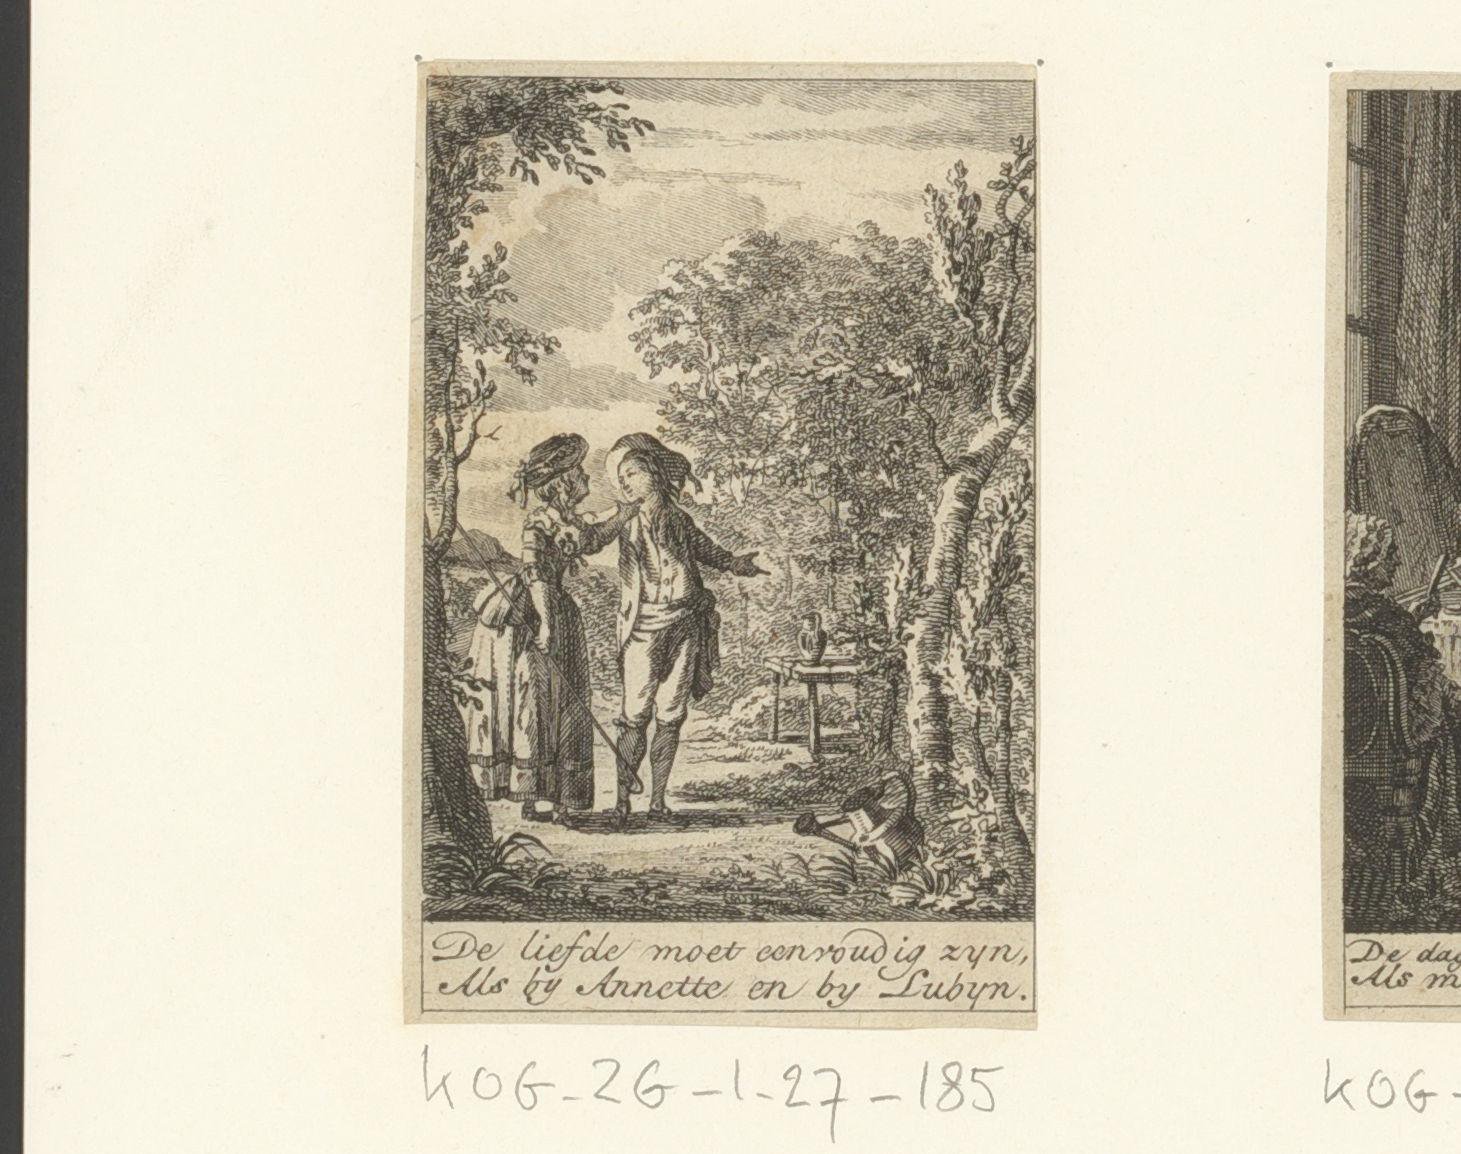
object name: print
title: Annette en Lubijn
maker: Anonymous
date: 1725-1799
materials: paper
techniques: engraving, etching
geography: netherlands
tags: lovers' meeting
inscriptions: collector's mark, collector's mark: Lugt 1641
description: Gebruikt als illustratie in een onbekende almanak.